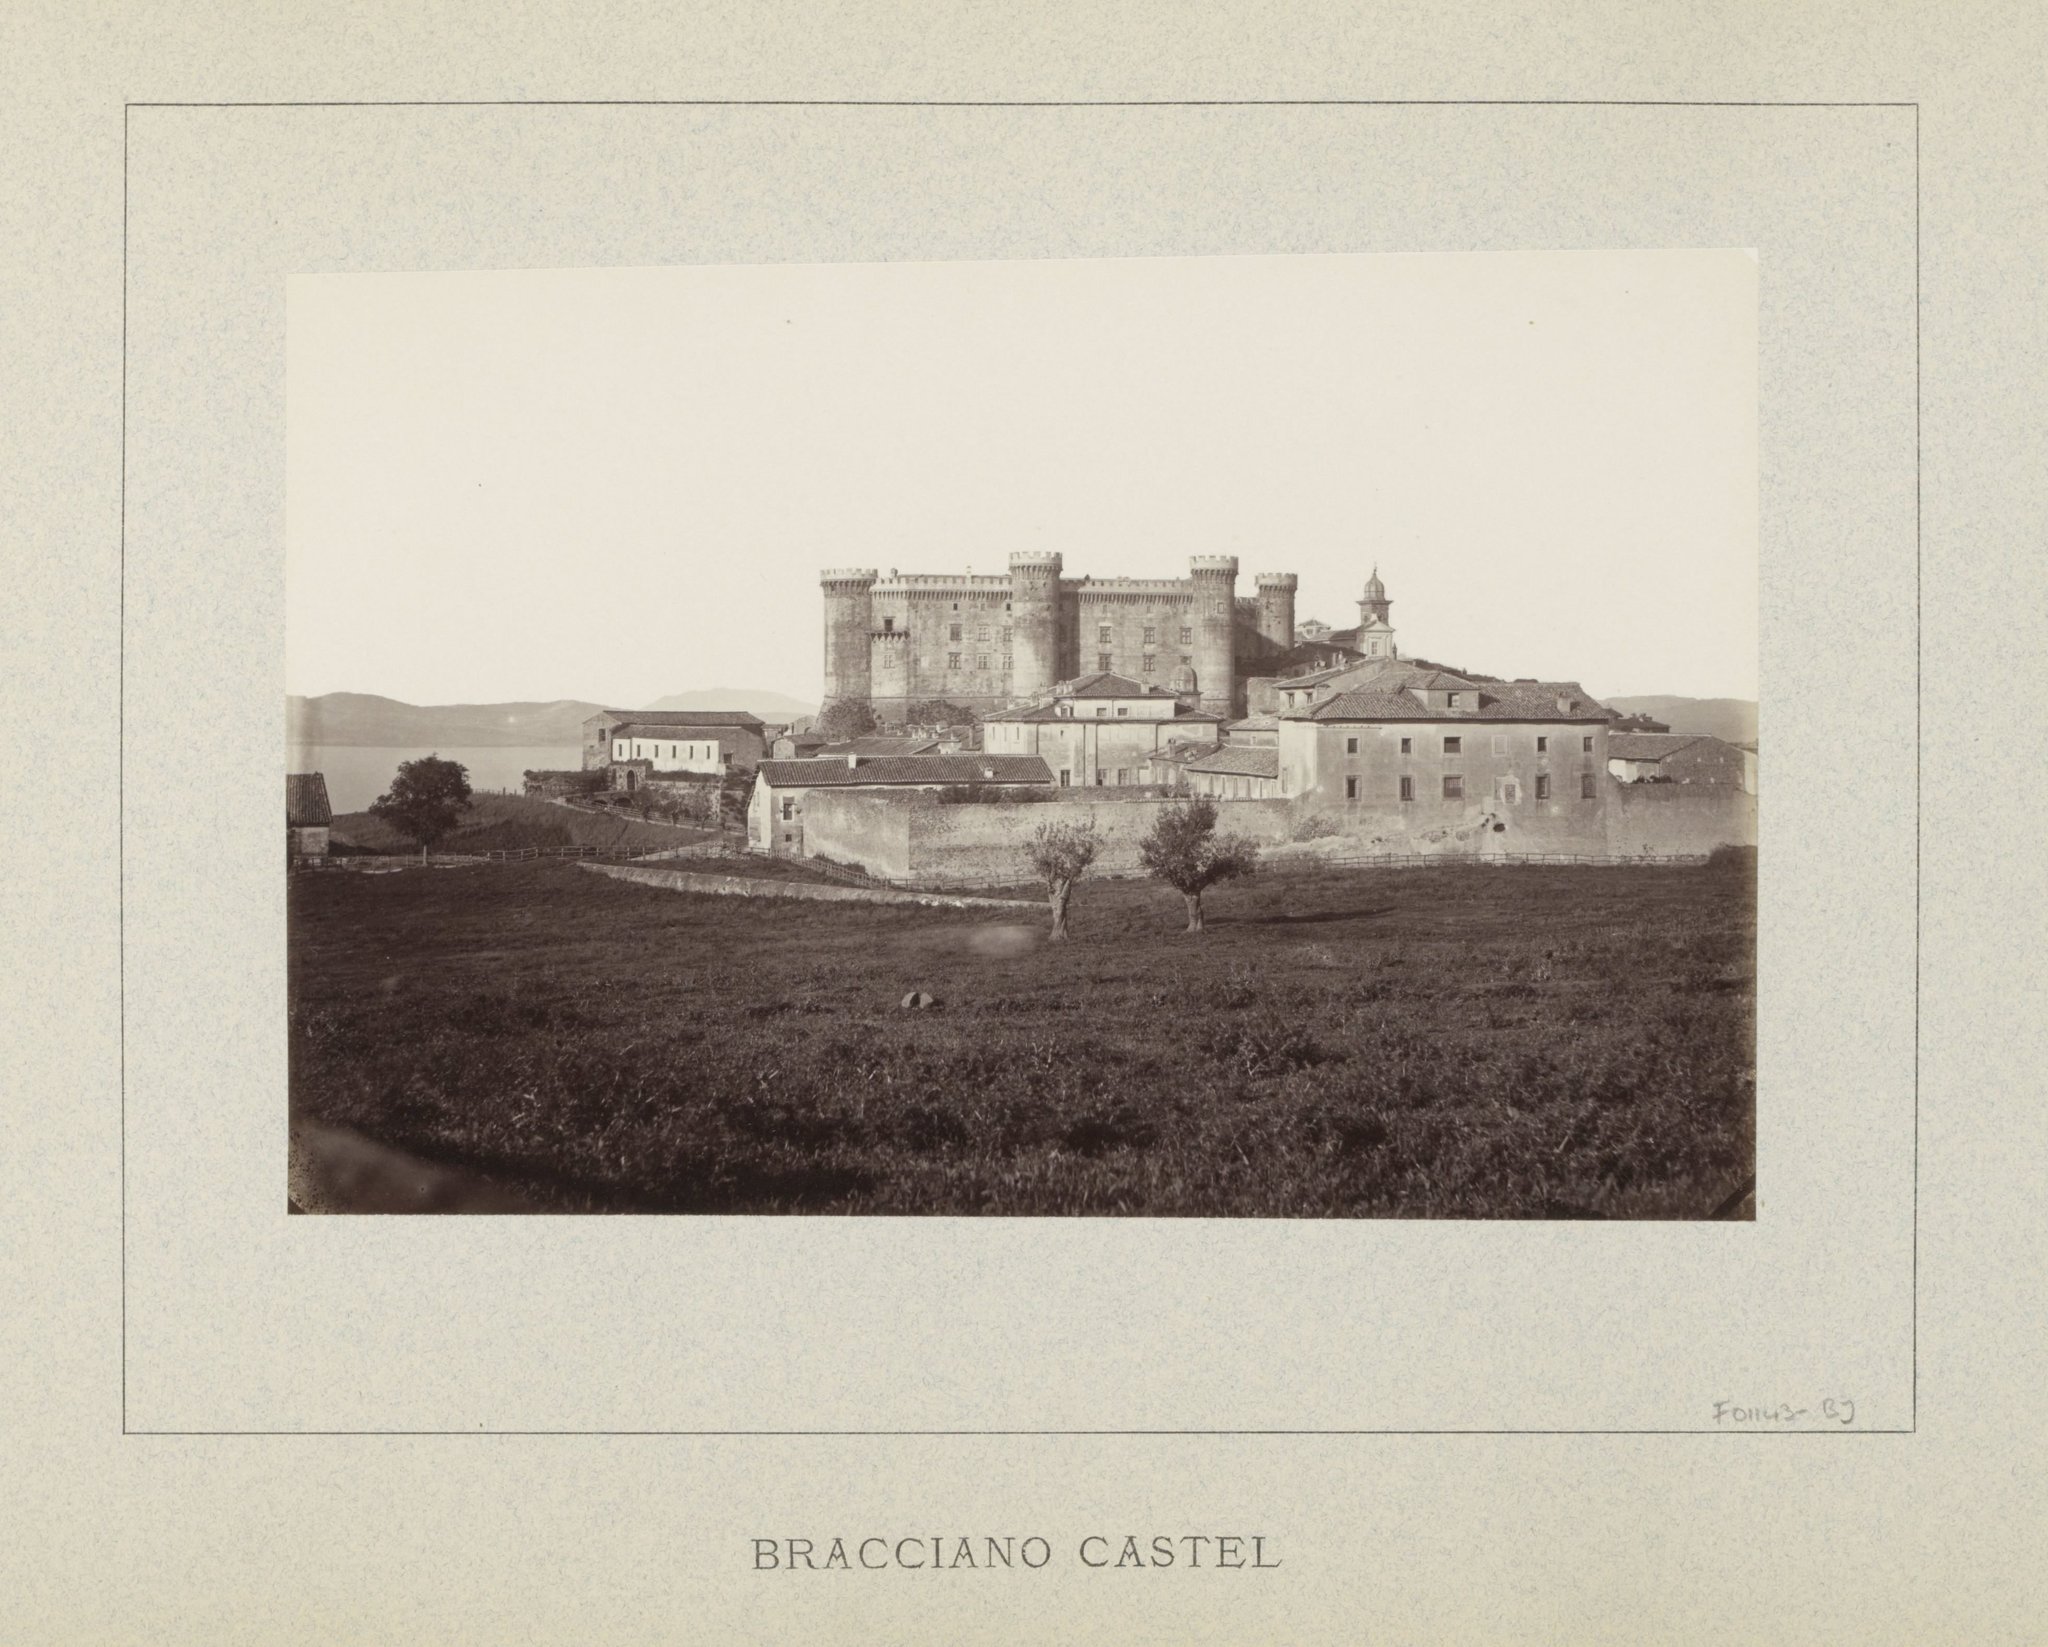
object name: photograph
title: Bracciano Castel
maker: Anonymous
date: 1860-1900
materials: photographic support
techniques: albumen print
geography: bracciano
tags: landscape with tower or castle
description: Onderdeel van Fotoalbum met opnames van bezienswaardigheden en kunstwerken in Rome.